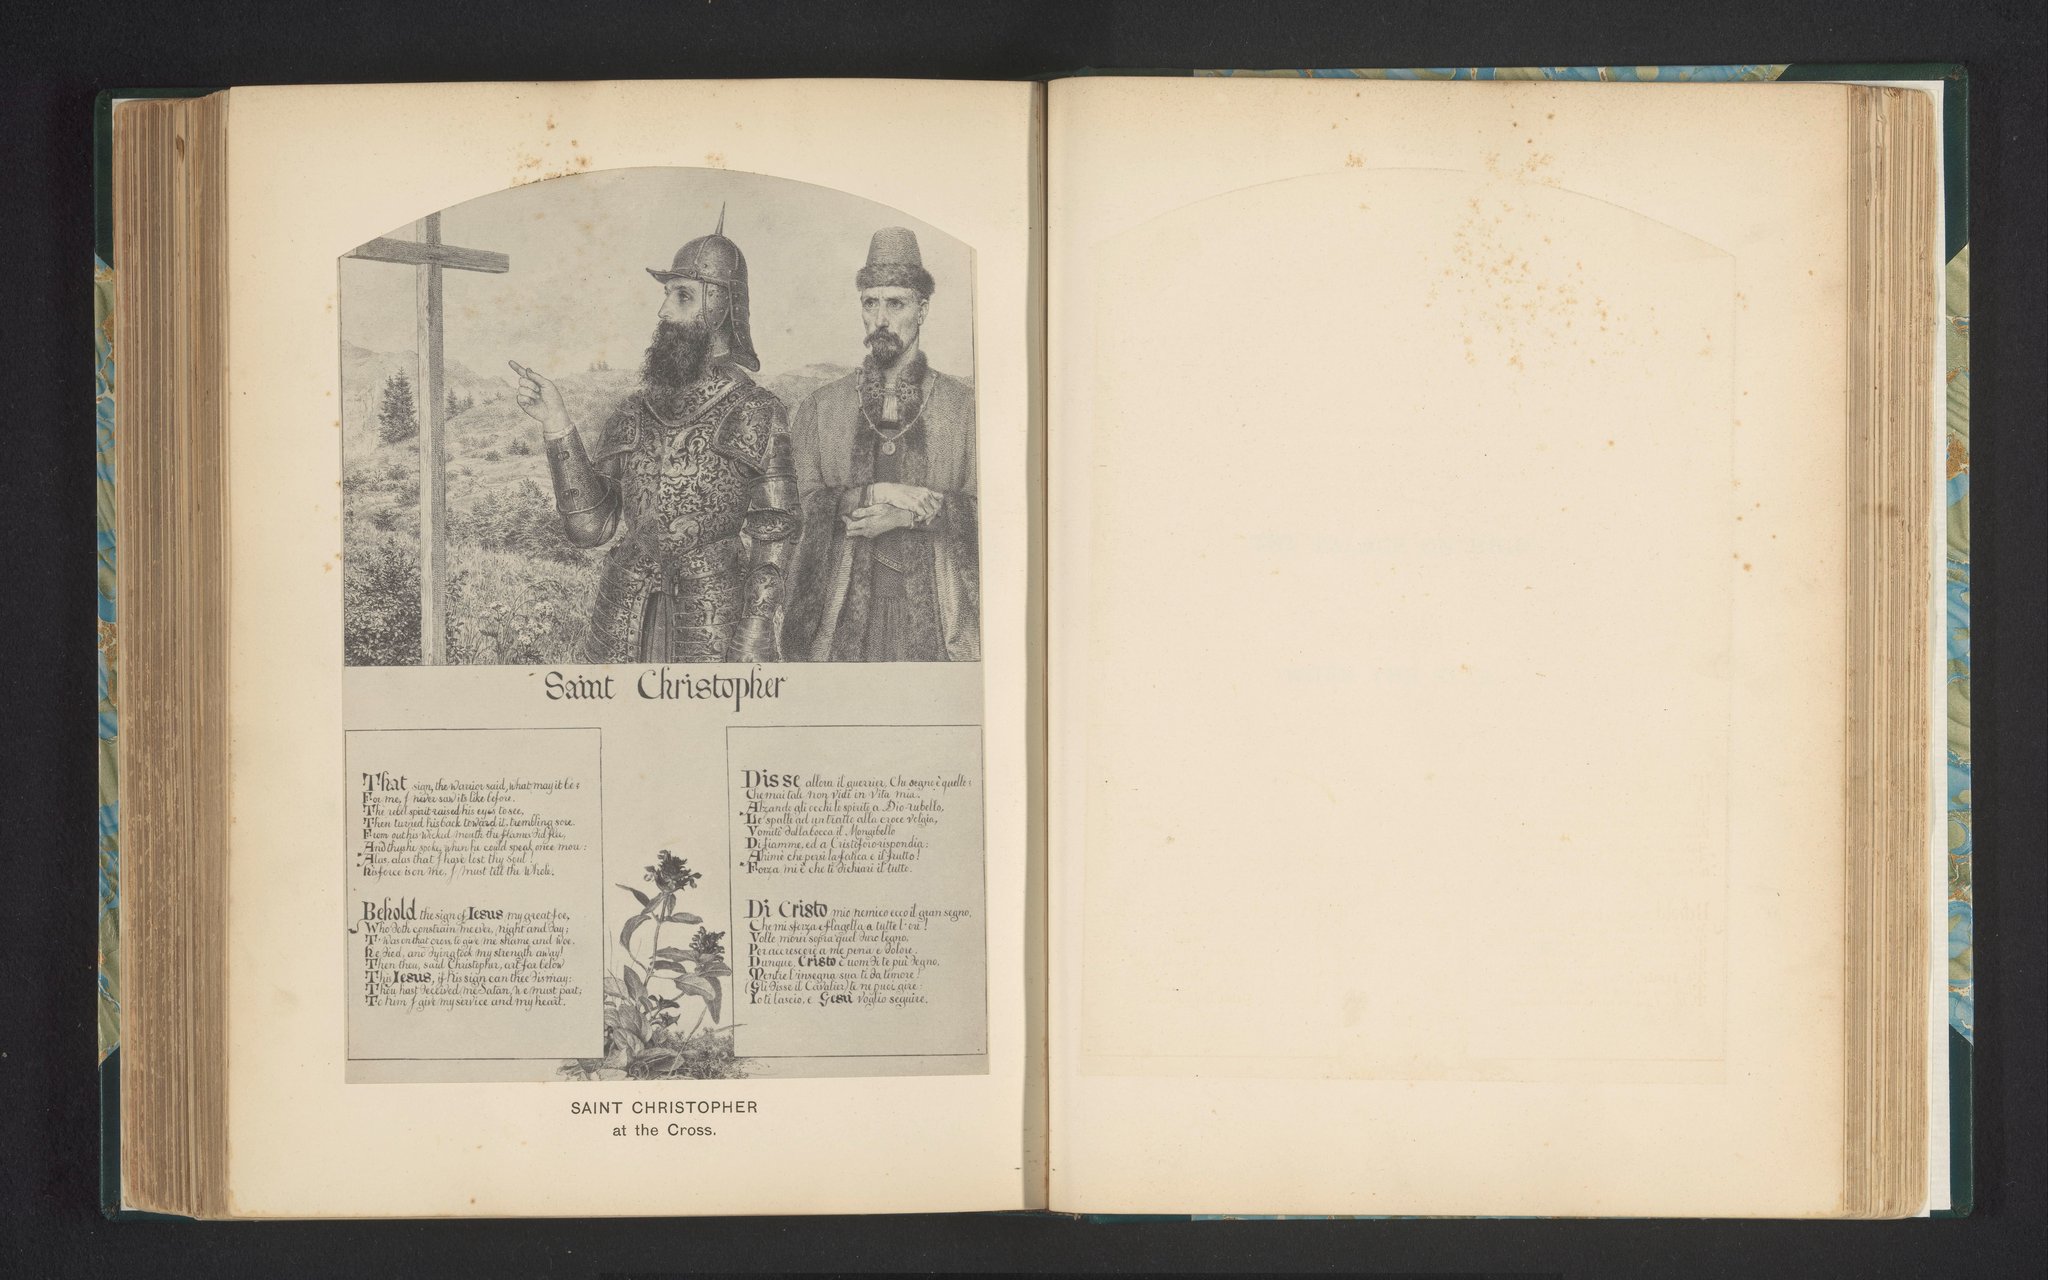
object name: photograph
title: Saint Christopher at the cross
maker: frederick hollyer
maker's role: fotograaf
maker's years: 1838-1933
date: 1875-1885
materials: photographic support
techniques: platinum process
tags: st. christopher serving the devil, who is scared of the cross